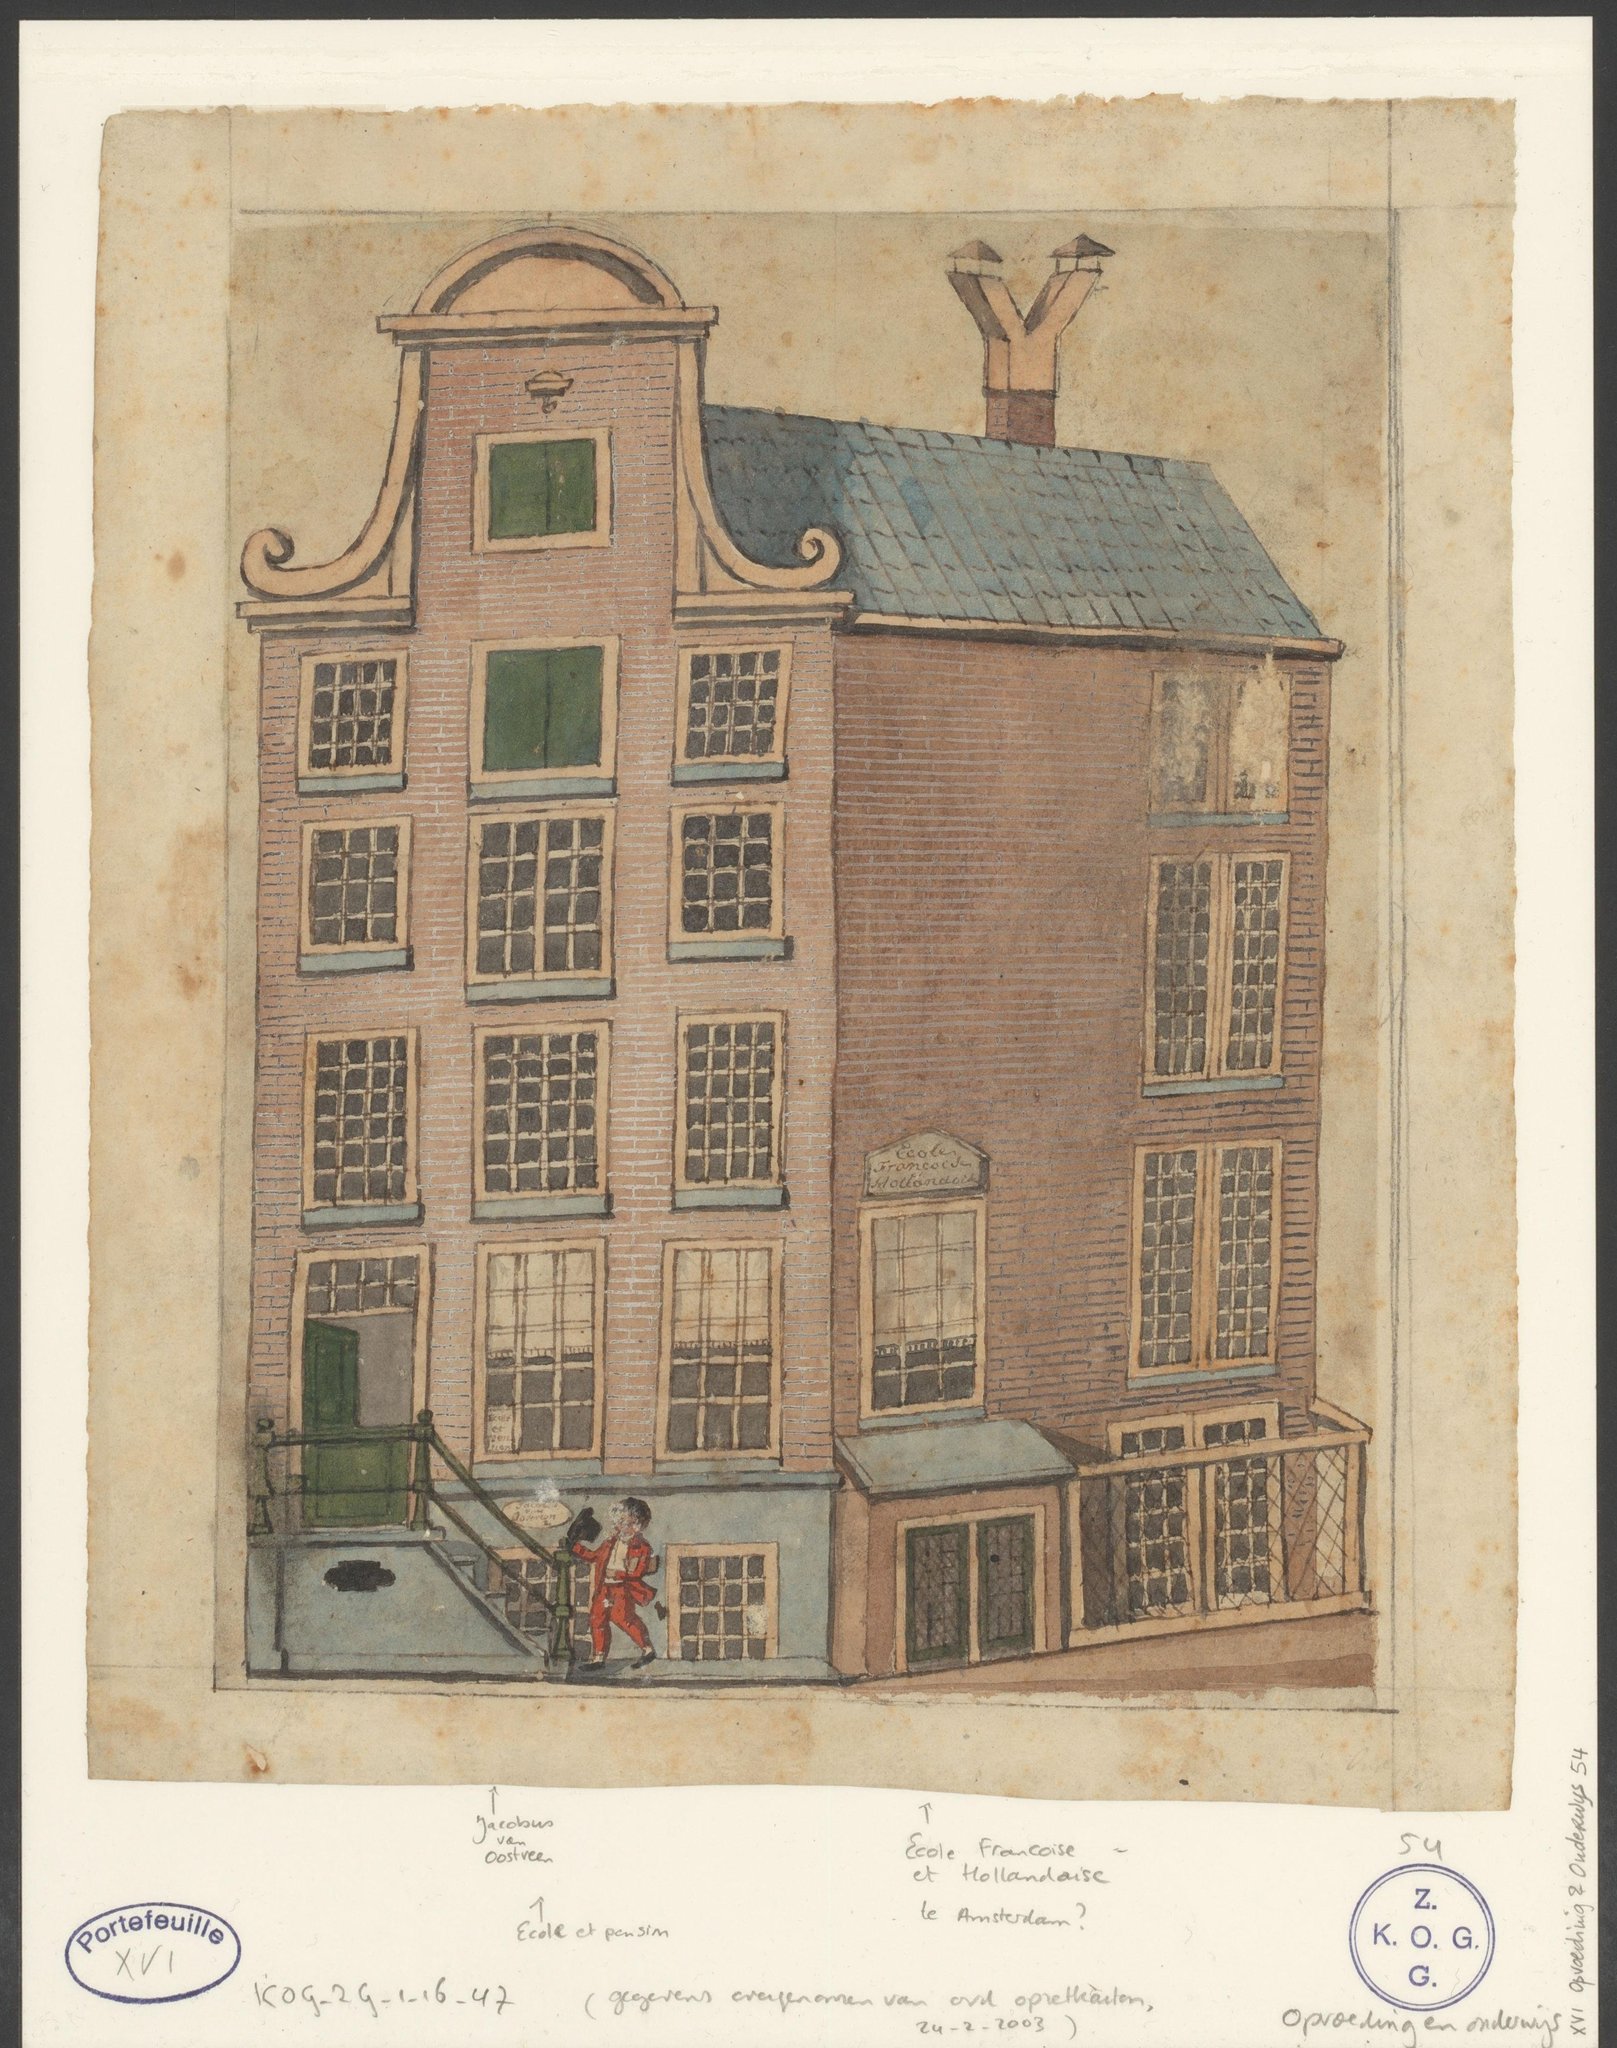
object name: drawing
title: Kind loopt een school binnen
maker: Anonymous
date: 1800-1899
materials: ink, paper, watercolor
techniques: brush, pen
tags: going to school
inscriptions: stamp, collector's mark: Lugt 1641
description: Kind, mogelijk Jacobus van Oostveen, loopt een school binnen. Op de school hangt een bord: Ecole Francoise Hollandaise. Onderwerpsrubrieken binnen de Atlas Zeden en Gewoonten: Onderwijs en Wetenschappen, Opvoeding en Onderwijs, Gebouwen voor het onderwijs bestemd.